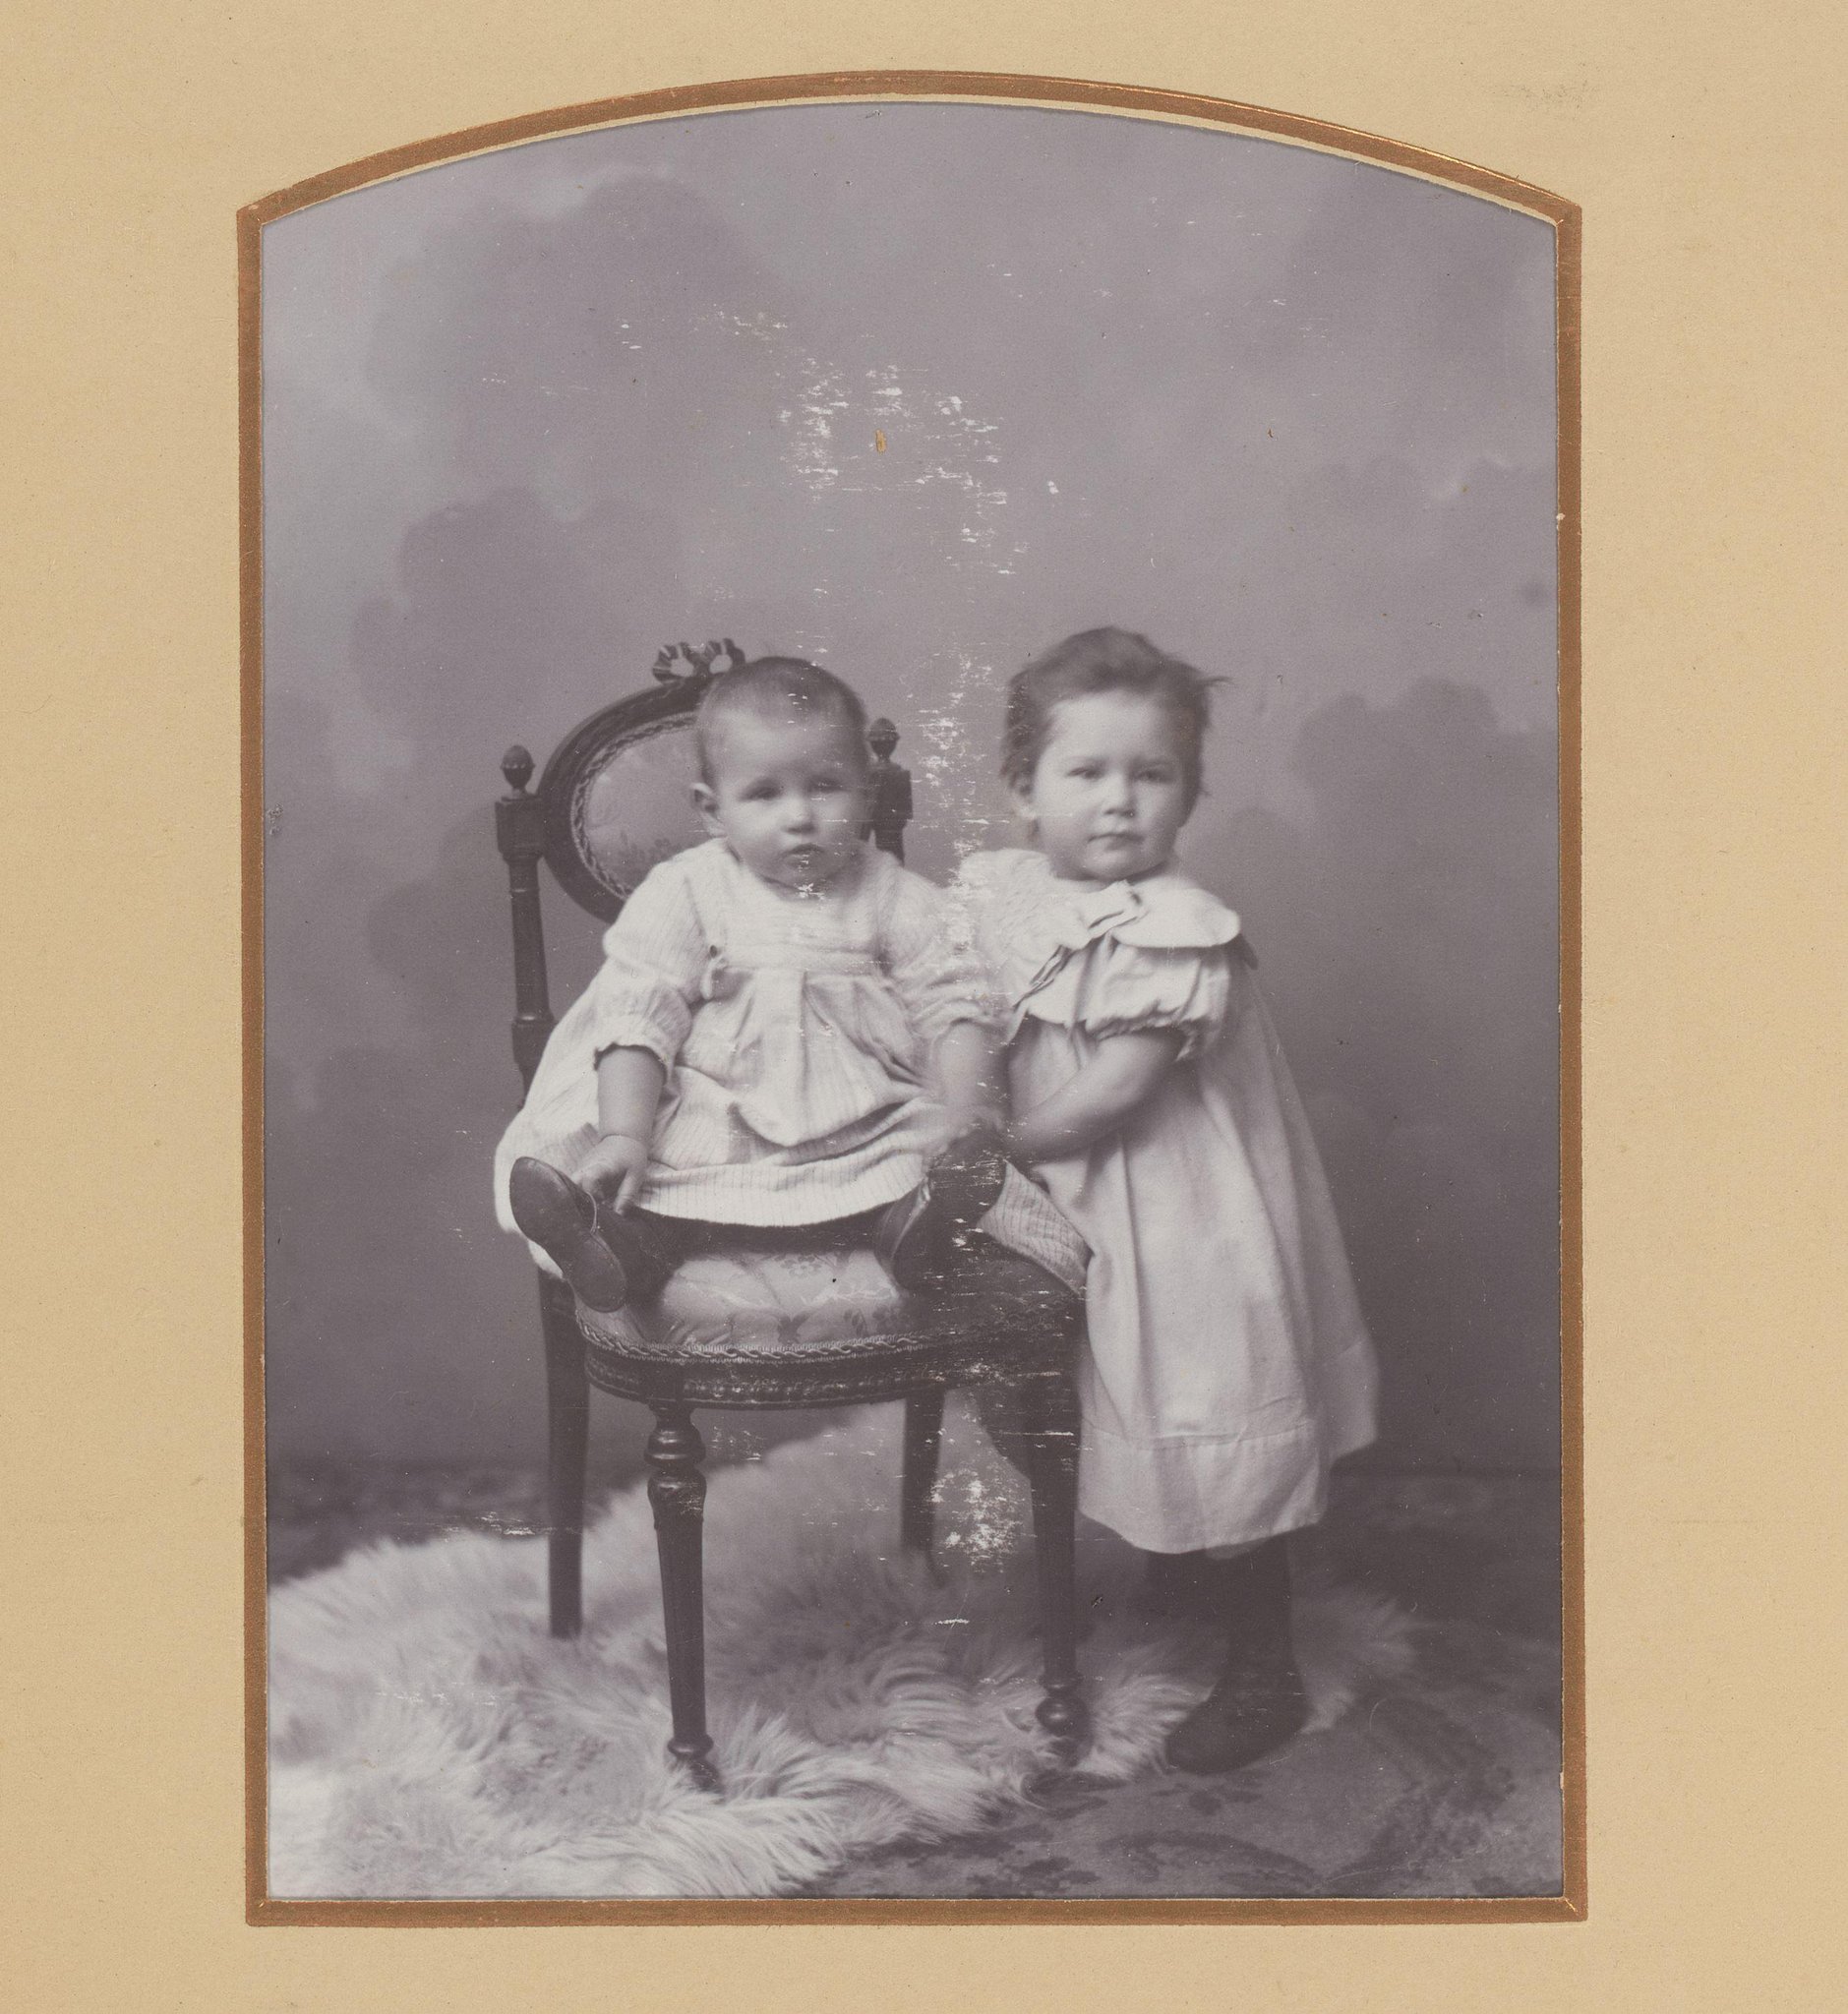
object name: cabinet photograph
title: Portret van een staand meisje en een zittende baby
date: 1888-1896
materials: cardboard, photographic support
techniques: collodion silver print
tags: historical persons - bb - woman, toddler (female), infant, baby ~ the ages of man, standing figure - aa - female human figure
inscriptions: inscription: ‘C.J.L. Vermeulen/ den Haag/ Toussaintkade 11/ Intercommunal Telephoon: 774./ Amsterdam/ Heerenstraat 6./ Heiligenweg hoek Singel./ Telephoon No 2340./ Utrecht/ Nieuwe gracht 50./ Telephoon No. 750.’